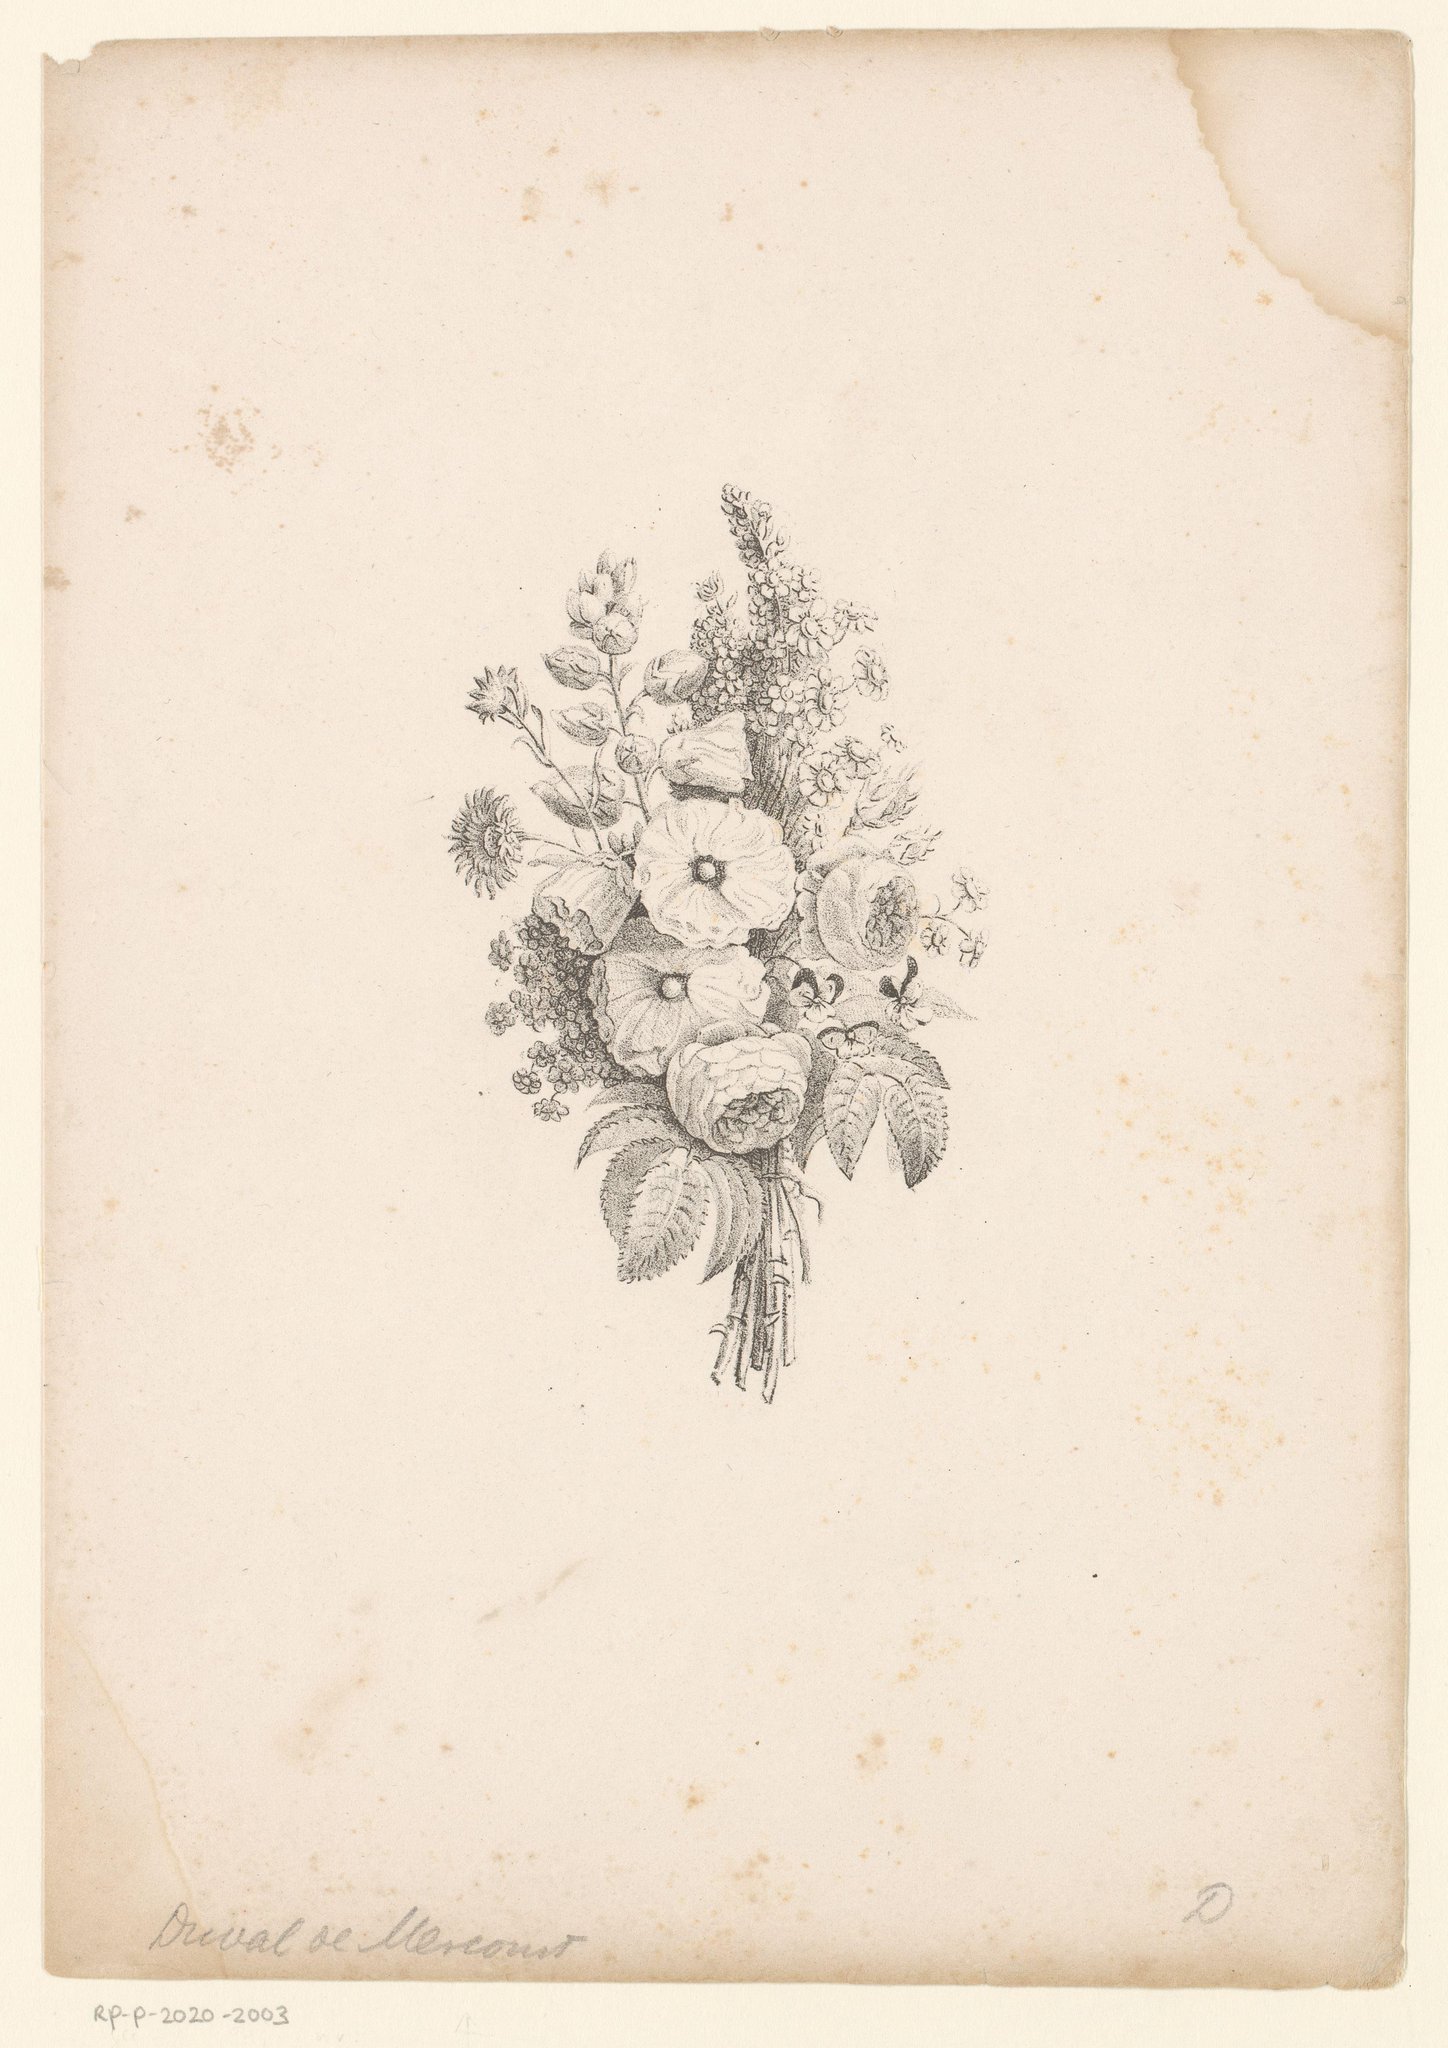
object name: print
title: Bos met pioenrozen, viooltjes, nieskruid en andere bloemen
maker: m. j. v. duval de mercourt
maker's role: print maker, printer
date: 1818-1821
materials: paper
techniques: lithograph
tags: cut flowers; nosegay, bunch of flowers, flowers: peony, flowers: viola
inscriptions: collector's mark: Lugt 2228, inscription: ‘Duval de Mercourt’